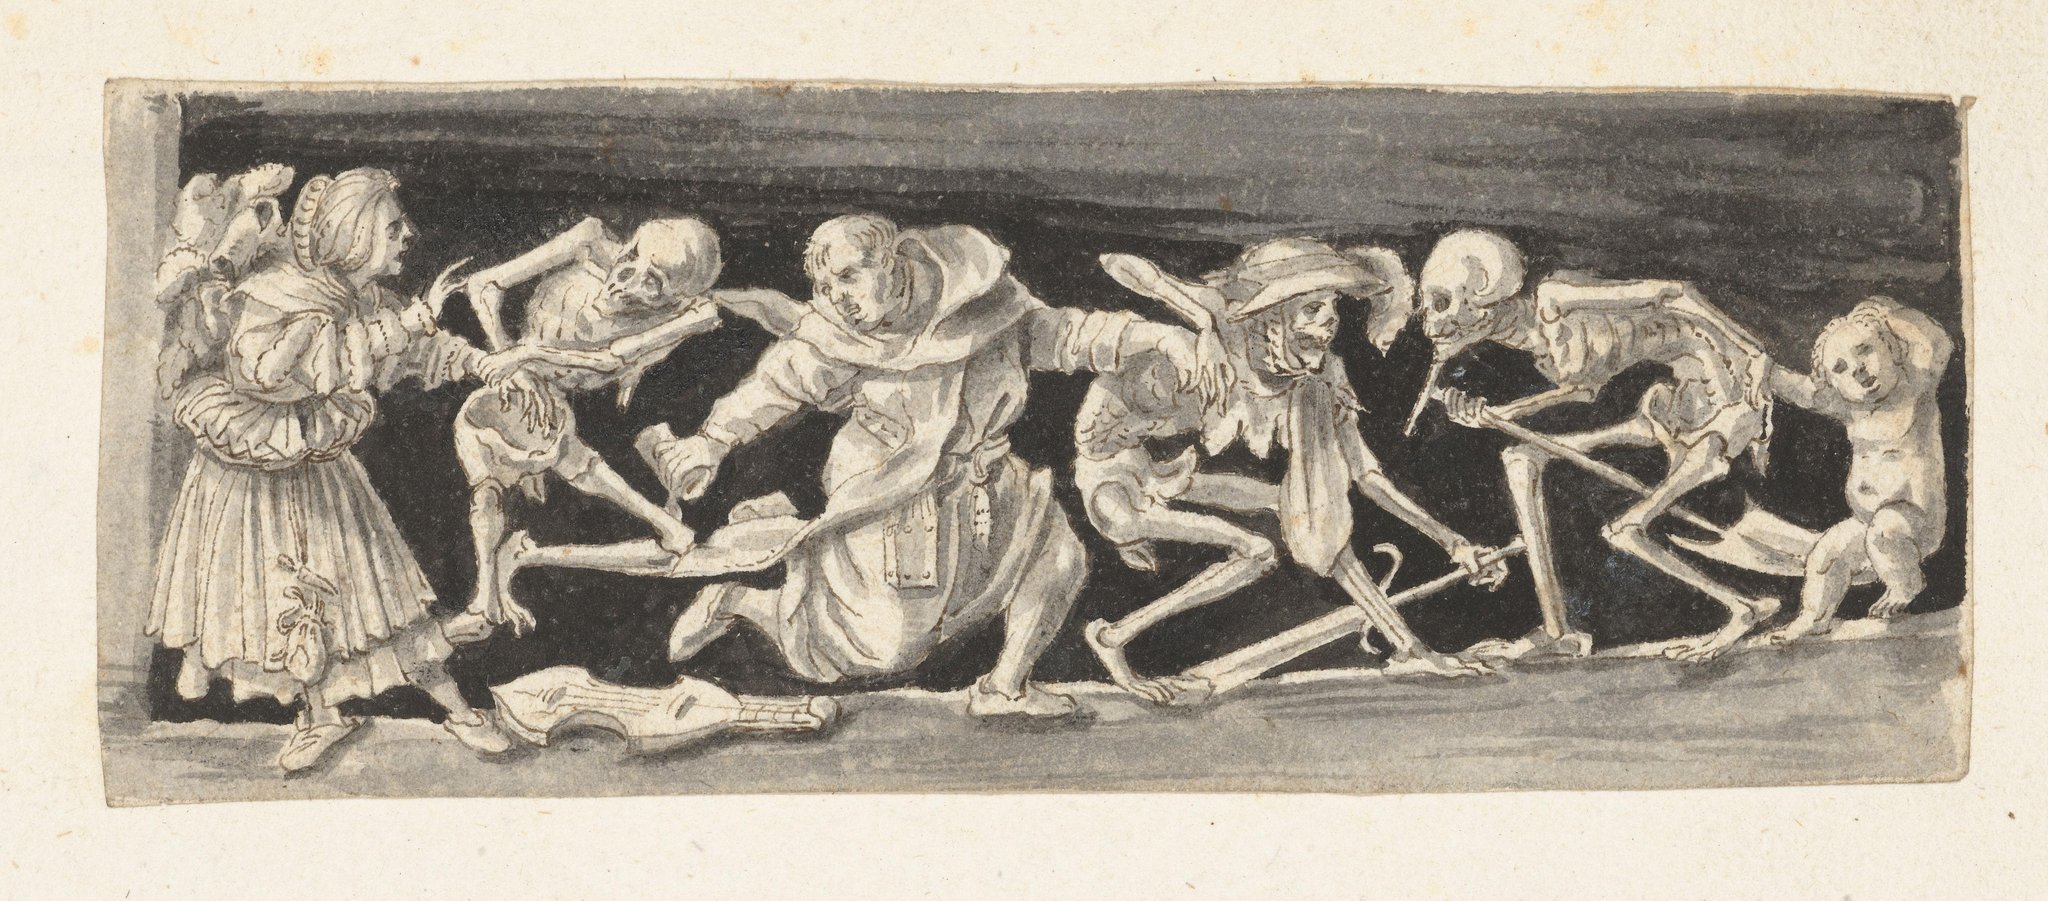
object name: watercolor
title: Dans van de Dood (rechterhelft)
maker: gesina ter borch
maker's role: draughtsman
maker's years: 1633-1690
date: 1643-1687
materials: ink, paper, watercolor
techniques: brush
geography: zwolle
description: Opgeplakte tekening met kopie naar een helft van een 16e eeuwse kopie naar een verloren ontwerp van Hans Holbein de Jonge voor een dolkschede.